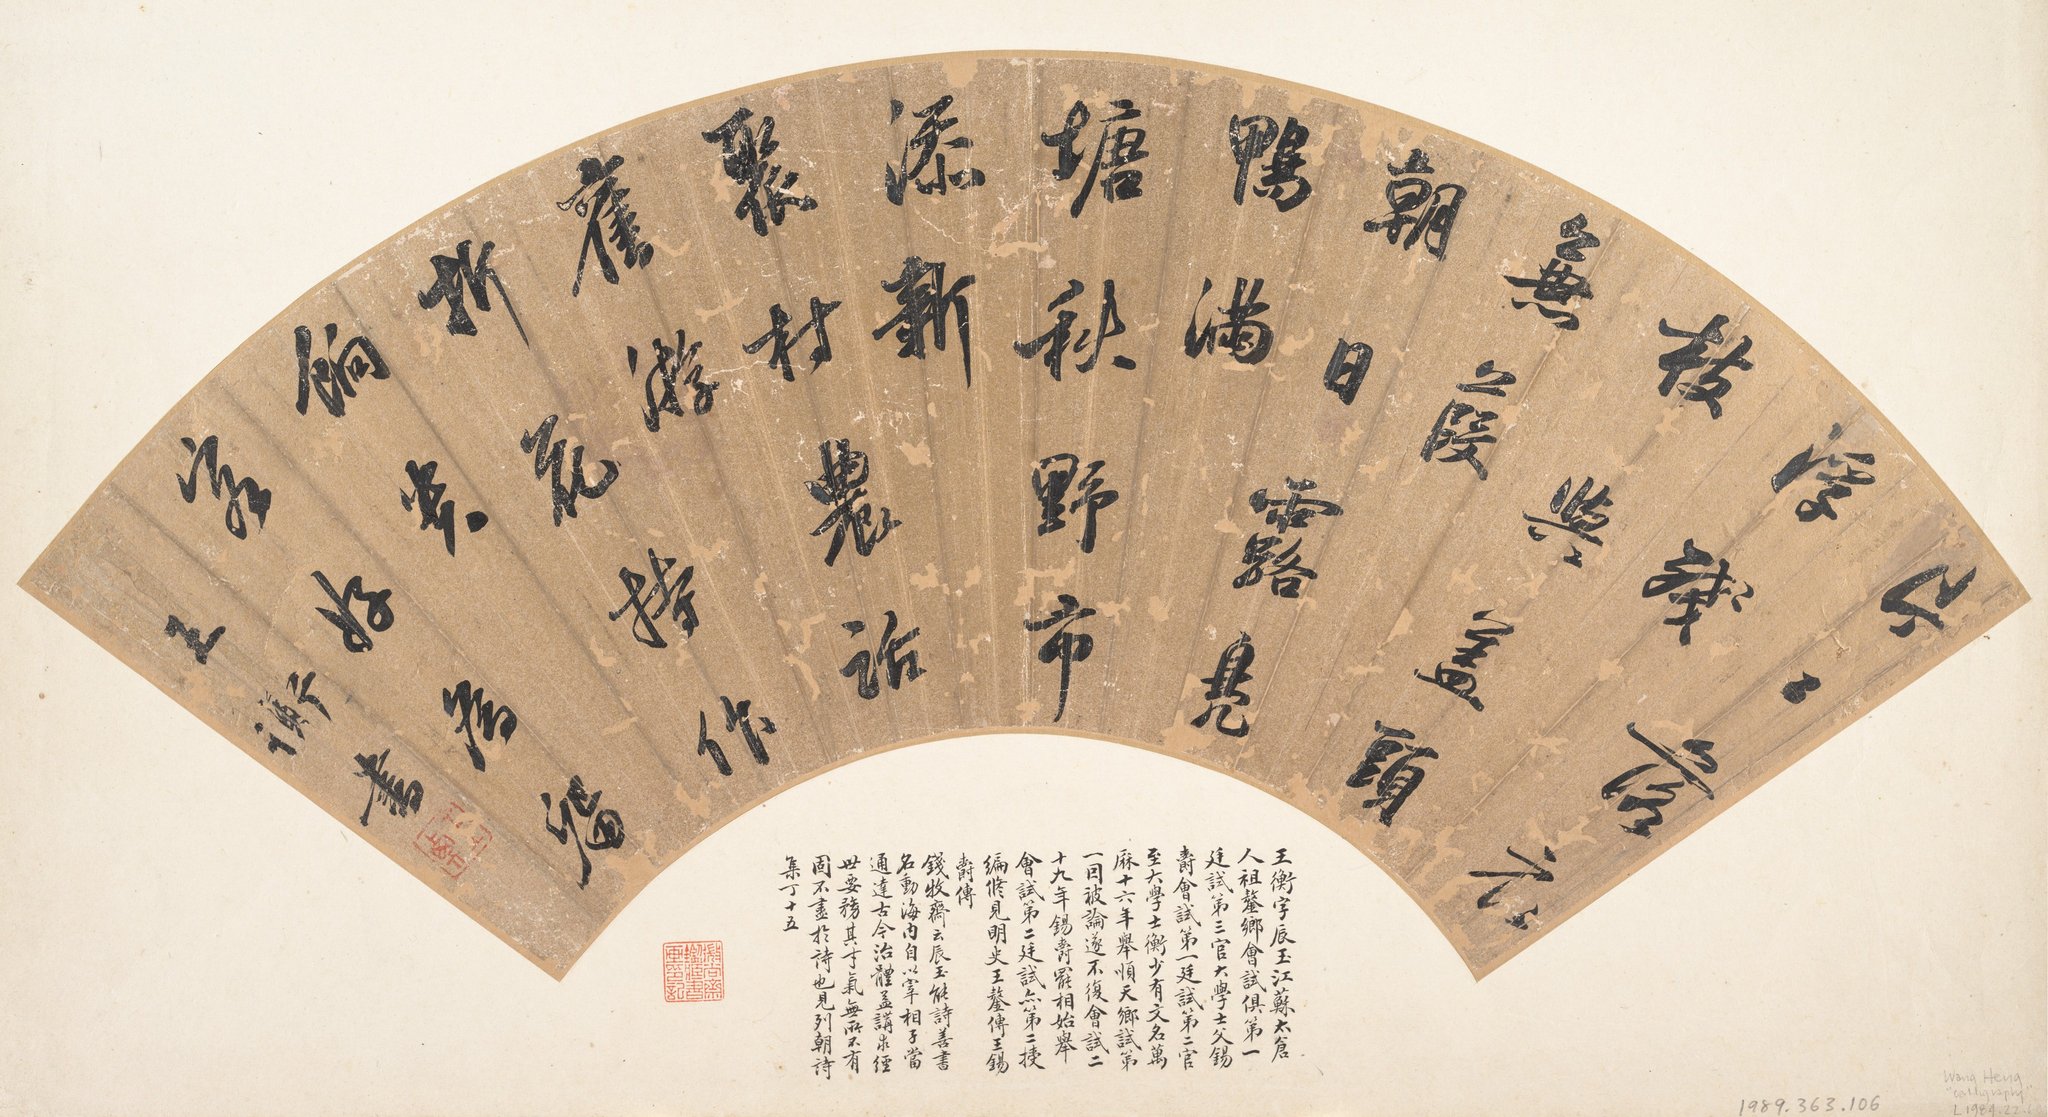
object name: folding fan mounted a an album leaf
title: Poem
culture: chinese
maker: wang heng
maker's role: artist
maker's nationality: chinese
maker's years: 1561-1609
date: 1561-1609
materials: gold, ink, paper